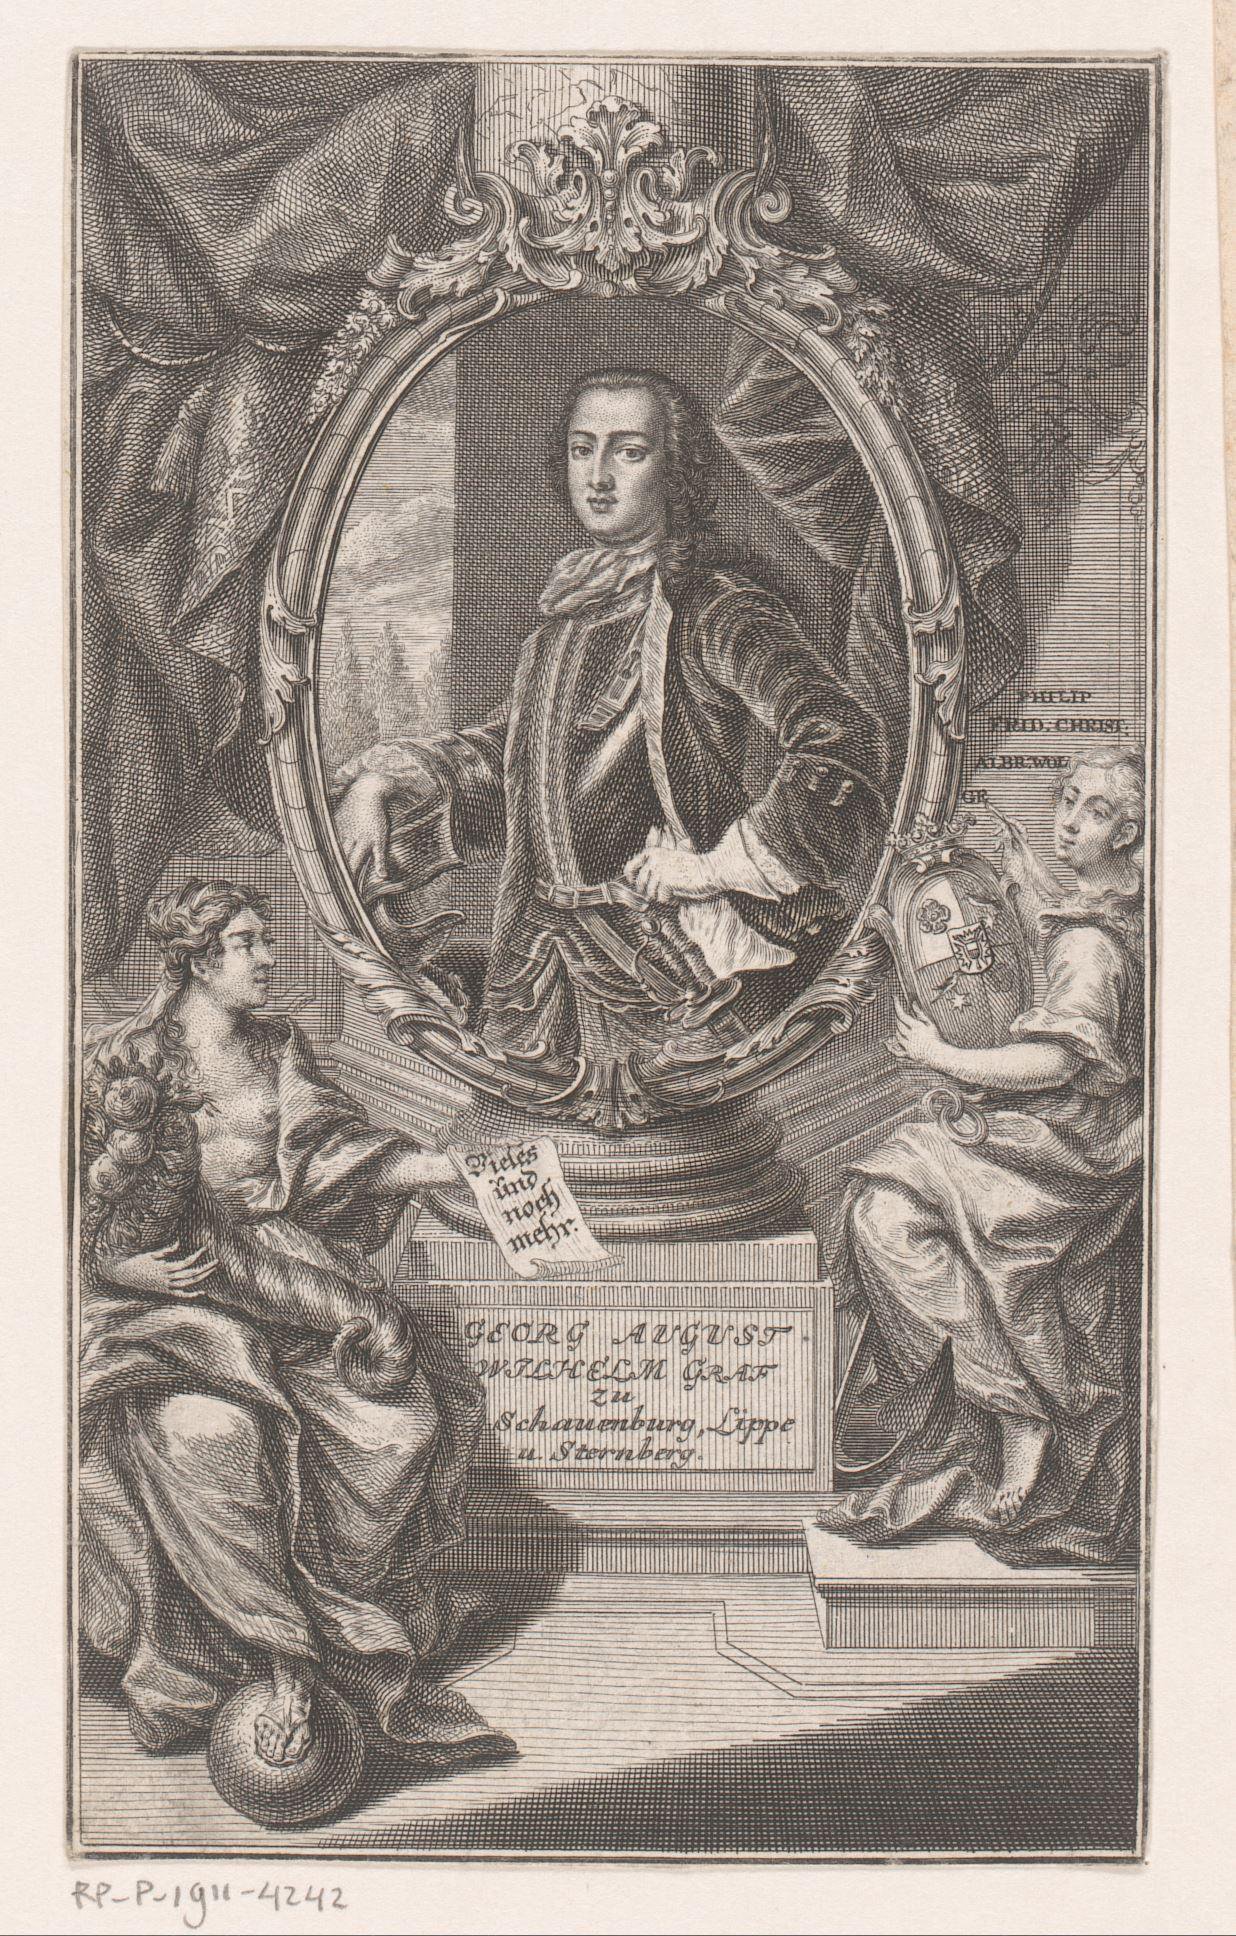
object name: print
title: Portret van Georg August Wilhelm, Erbgraf zu Schaumburg-Lippe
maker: martin tyroff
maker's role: print maker, publisher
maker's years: 1704-1779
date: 1750-1779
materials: paper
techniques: engraving, etching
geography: nuremberg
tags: london, earl, 'cornucopia', horn of plenty, historical persons, armorial bearing, heraldry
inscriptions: collector's mark: Lugt 2228